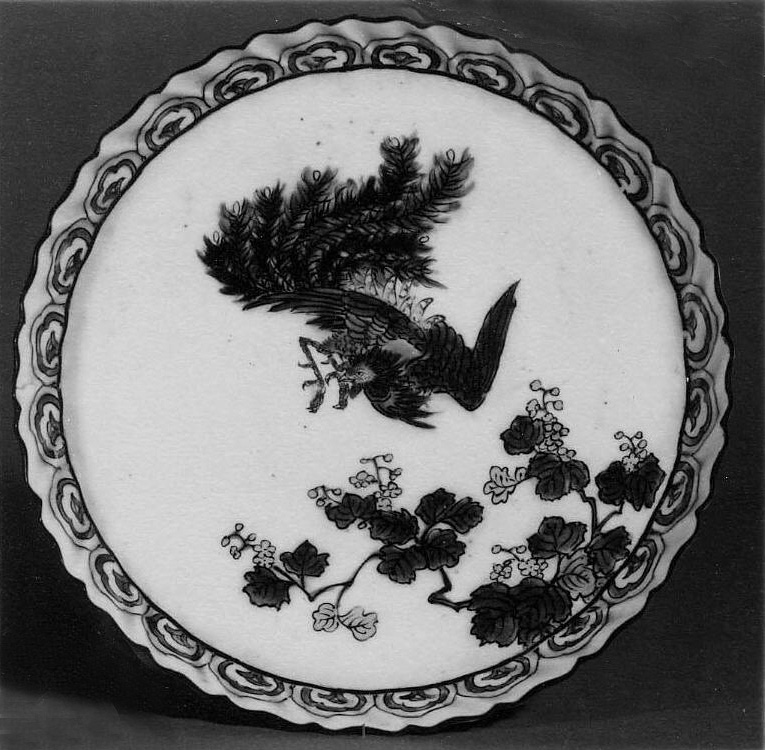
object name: plate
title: Dish with Phoenix and Flowering Branch Design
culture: japanese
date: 1601-1800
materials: enamel, porcelain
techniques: overglaze, polychrome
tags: phoenix